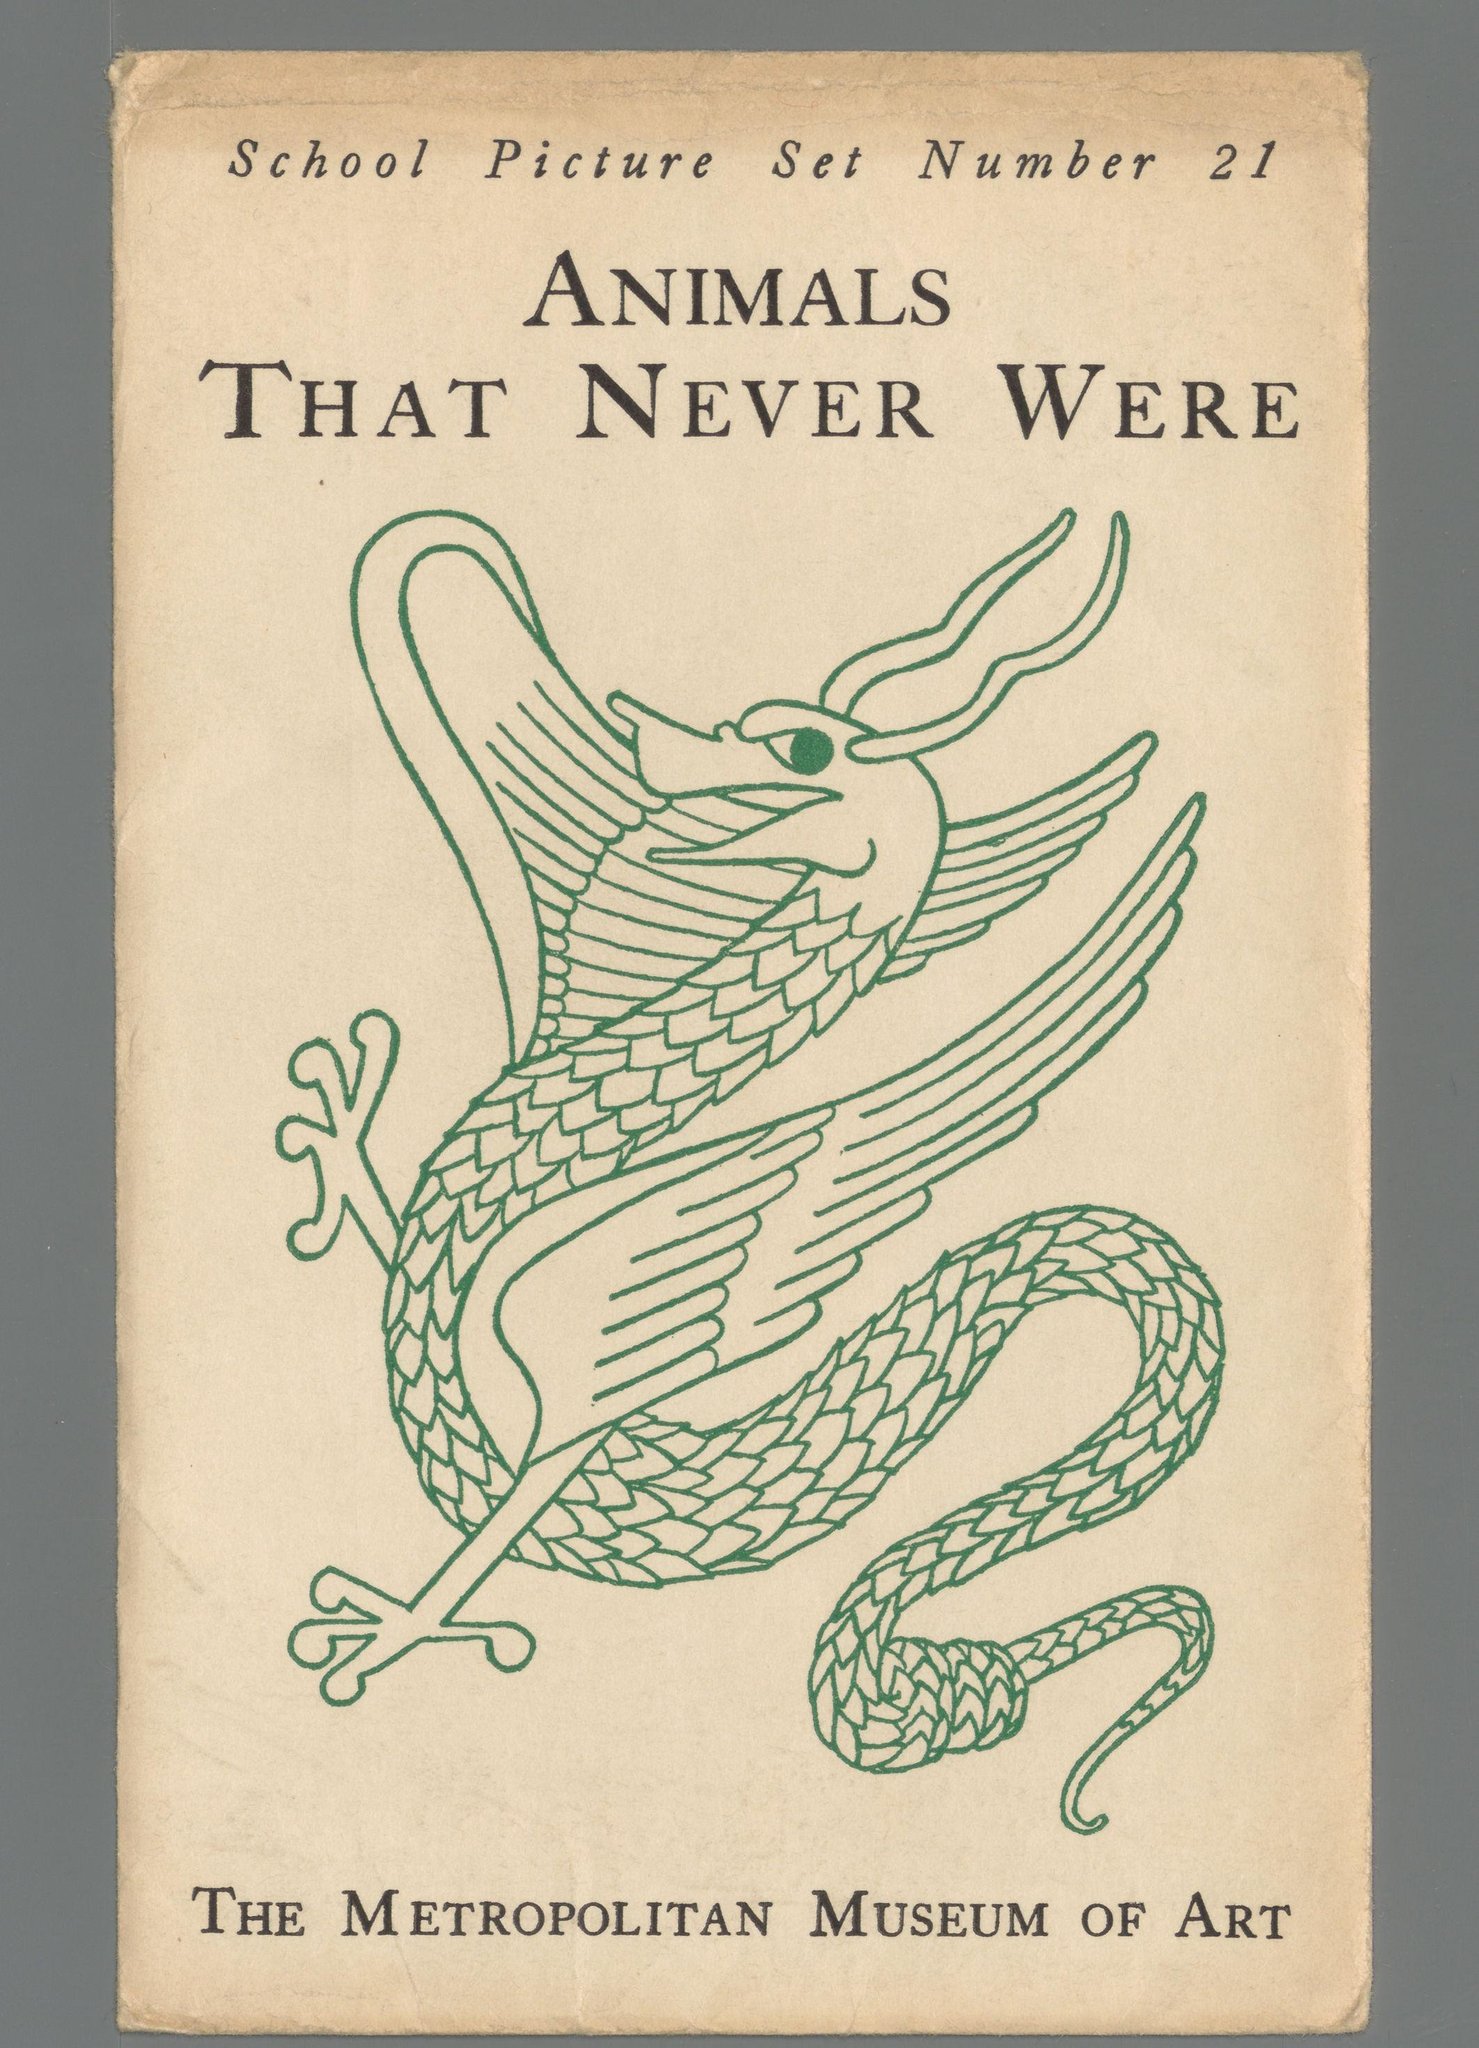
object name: photomechanical print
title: Envelop met educatieve kaarten van het Metropolitan Museum of Art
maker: Anonymous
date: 1935-1979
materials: cardboard, paper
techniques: printing block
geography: new york city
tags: fabulous animals ~ birds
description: Het object bestaat uit een envelop, een kaart met toelichting en vijftien kaarten met afbeeldingen en beschrijvingen van objecten met niet bestaande/ mythologische wezens. De kaarten zijn bestemd voor scholen om te gebruiken als educatief materiaal.